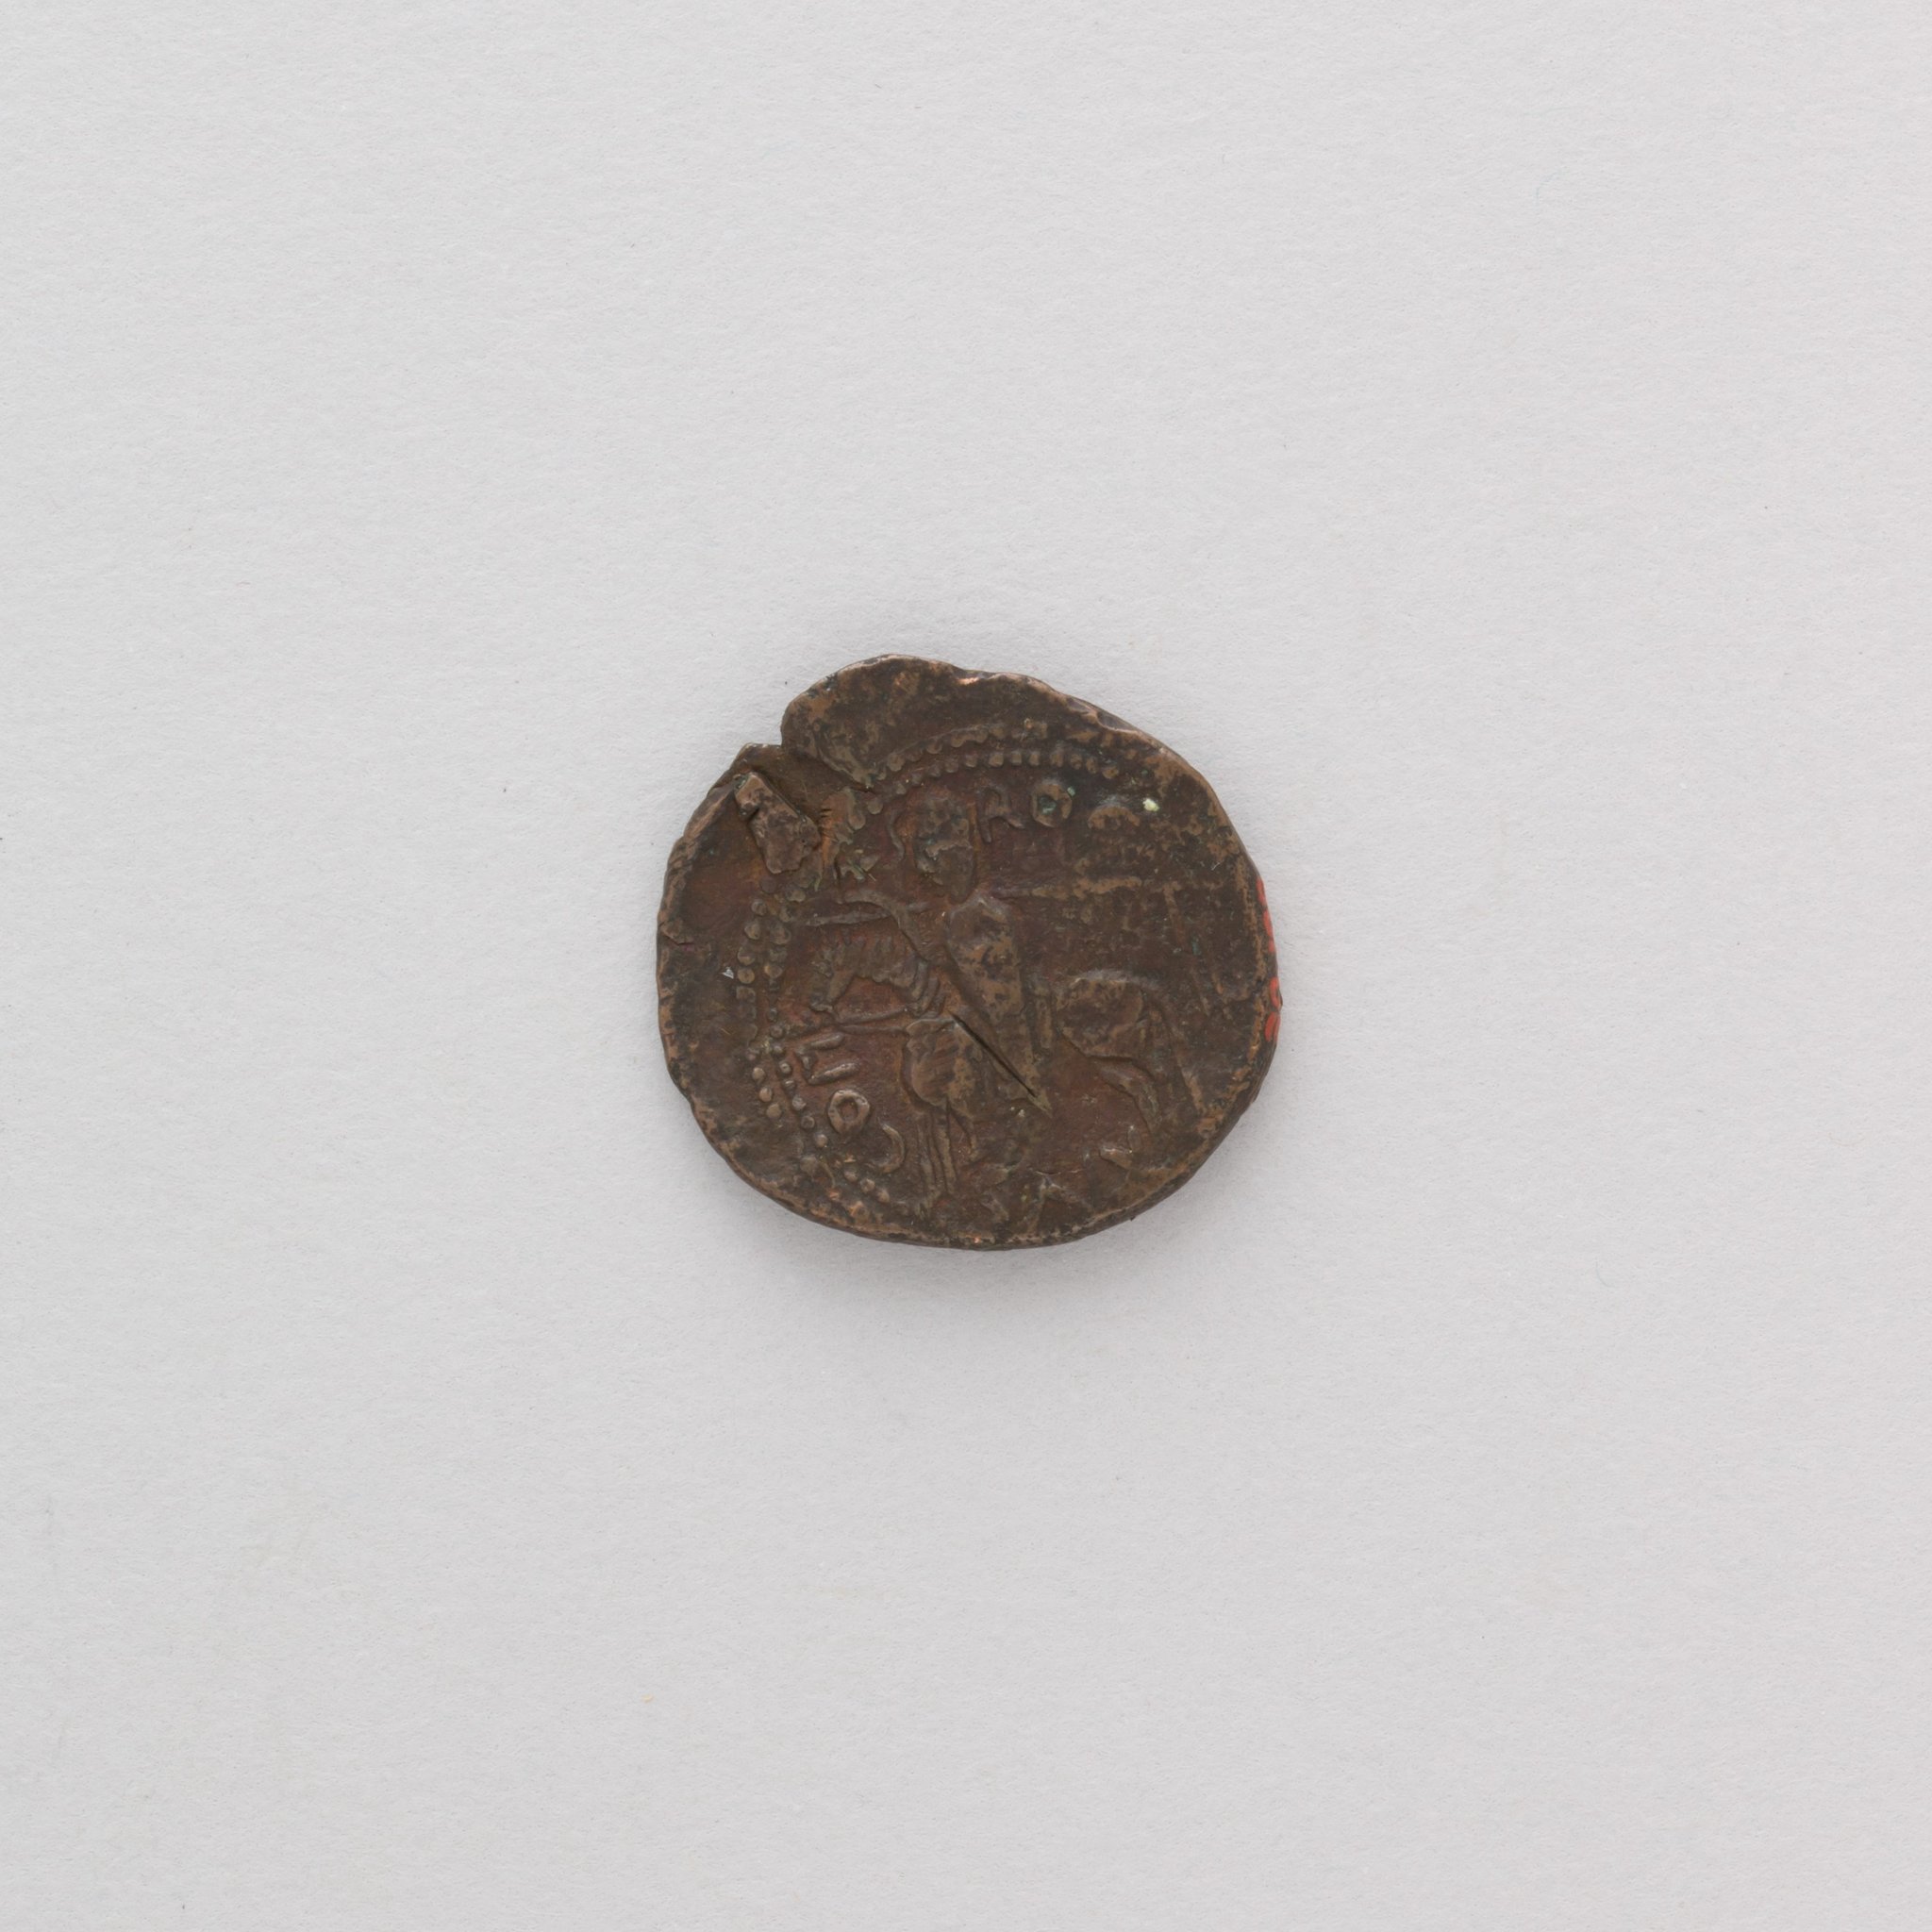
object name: coin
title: Coin of Roger I, Duke of Sicily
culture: italian, sicilian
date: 1072-1105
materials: bronze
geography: italy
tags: horses,coins